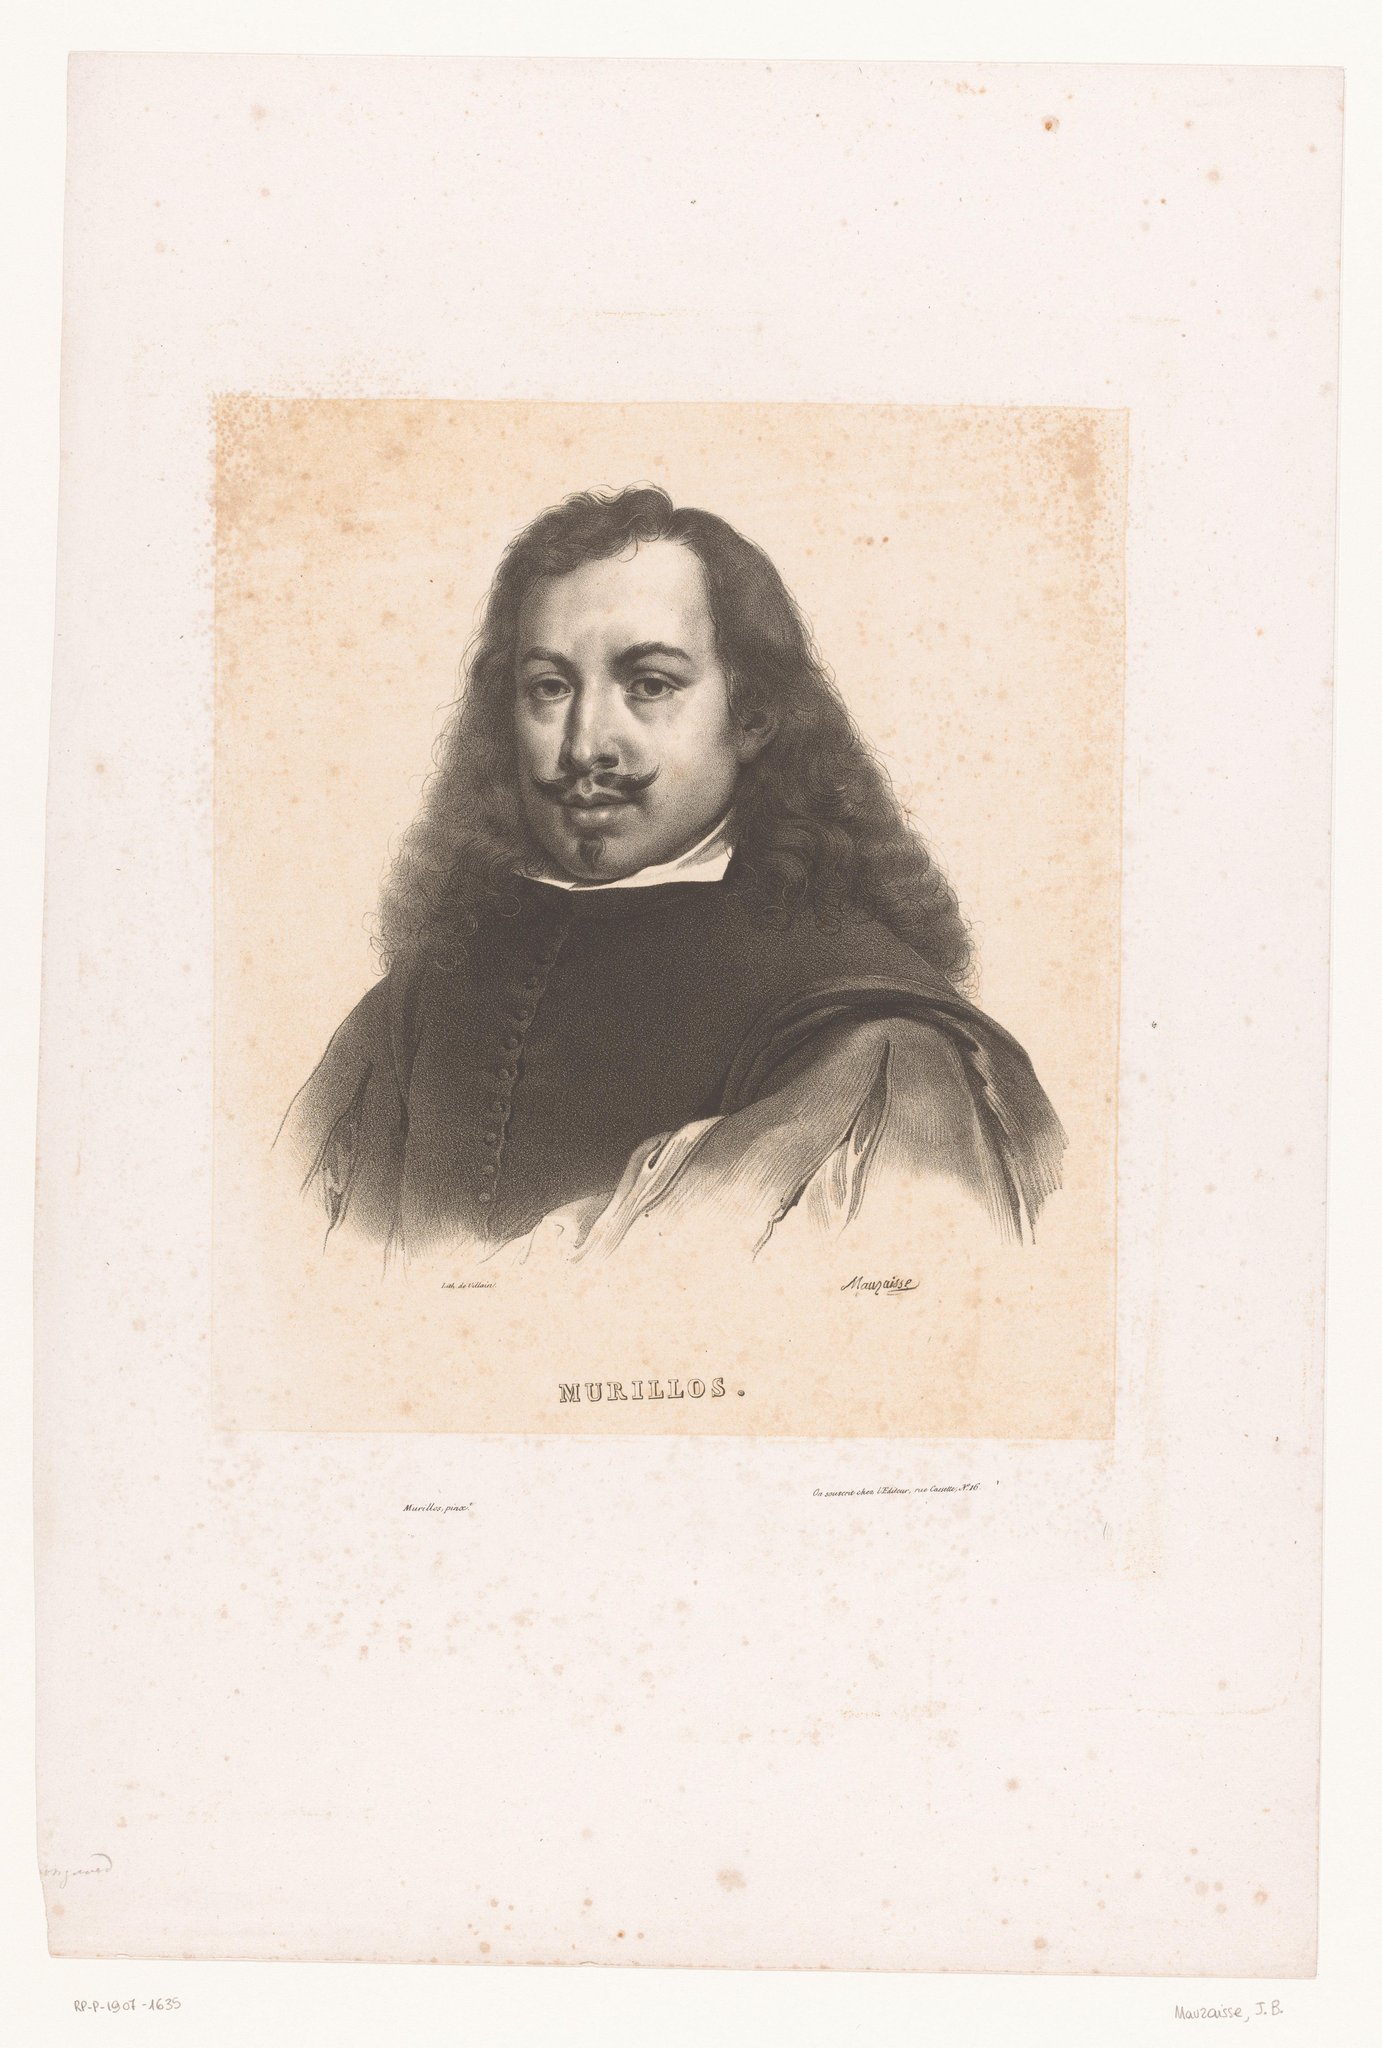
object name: print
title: Portret van Bartolomé Esteban Murillo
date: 1822-1852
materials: paper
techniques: tone lithography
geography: paris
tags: sevilla, painter, draughtsman, bartolomé esteban murillo, scholar, philosopher, portrait, self-portrait of painter, historical persons (portraits and scenes from the life)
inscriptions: check stamp: ‘JC’, collector's mark: Lugt 2228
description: Prent waarschijnlijk ook gebruikt in: Chabert, Jean Claude. Galerie des peintres ou collection de portraits des peintres les plus célèbres de toutes les écoles. Accompagnée d'une notice sur chacun d'eux, et de copies de dessins originaux / Galerie des peintres ou collection de portraits des peintres les plus célèbres de toutes les écoles. Accompagnée de leur notice historique, de leurs dessins et d'un discours sur les arts. Parijs: Jean Claude Chabert, s.a. [1822-1834]. De samenstelling van tegenwoordig bekende en al dan niet gebonden exemplaren van deze uitgave verschillen. Dit omdat de prenten en bijhorende stukken tekst op inschrijving en waarschijnlijk ook los verkrijgbaar waren.